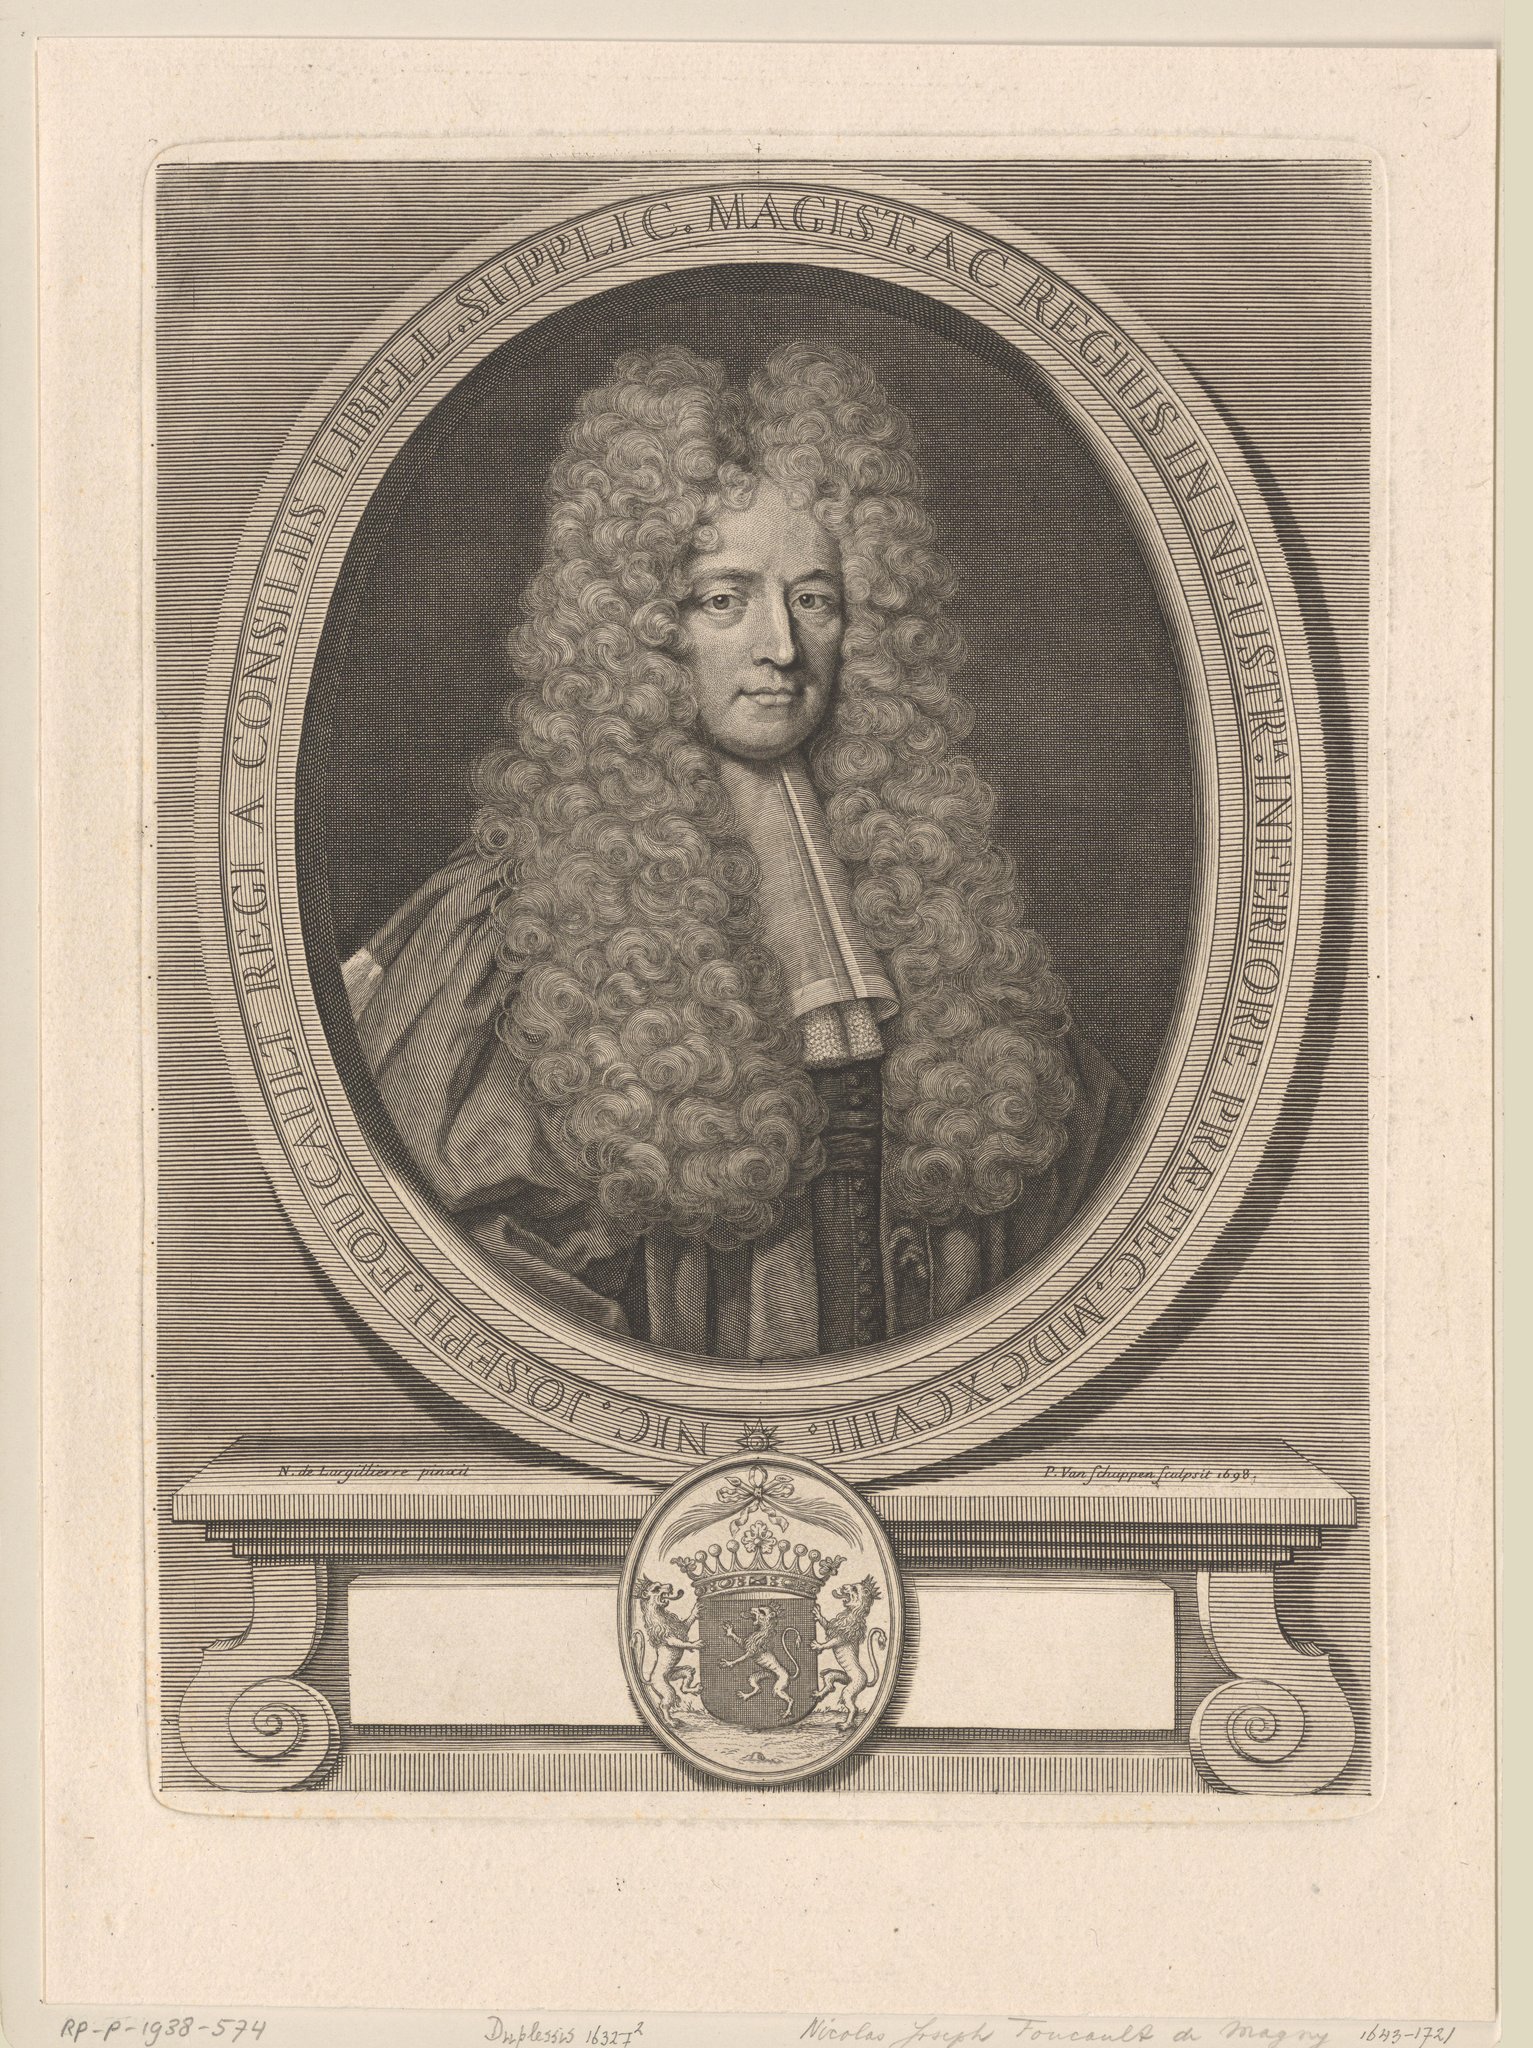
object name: print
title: Portret van Nicolas-Joseph Foucault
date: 1698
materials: paper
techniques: engraving, etching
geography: paris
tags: paris, historical persons, wig, armorial bearing, heraldry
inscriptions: collector's mark: Lugt 2228